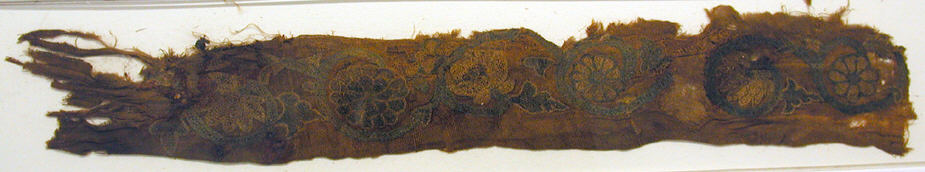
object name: embroidered strip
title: Embroidered Strip with Floral Scroll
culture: chinese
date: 1271-1368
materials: silk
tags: flowers